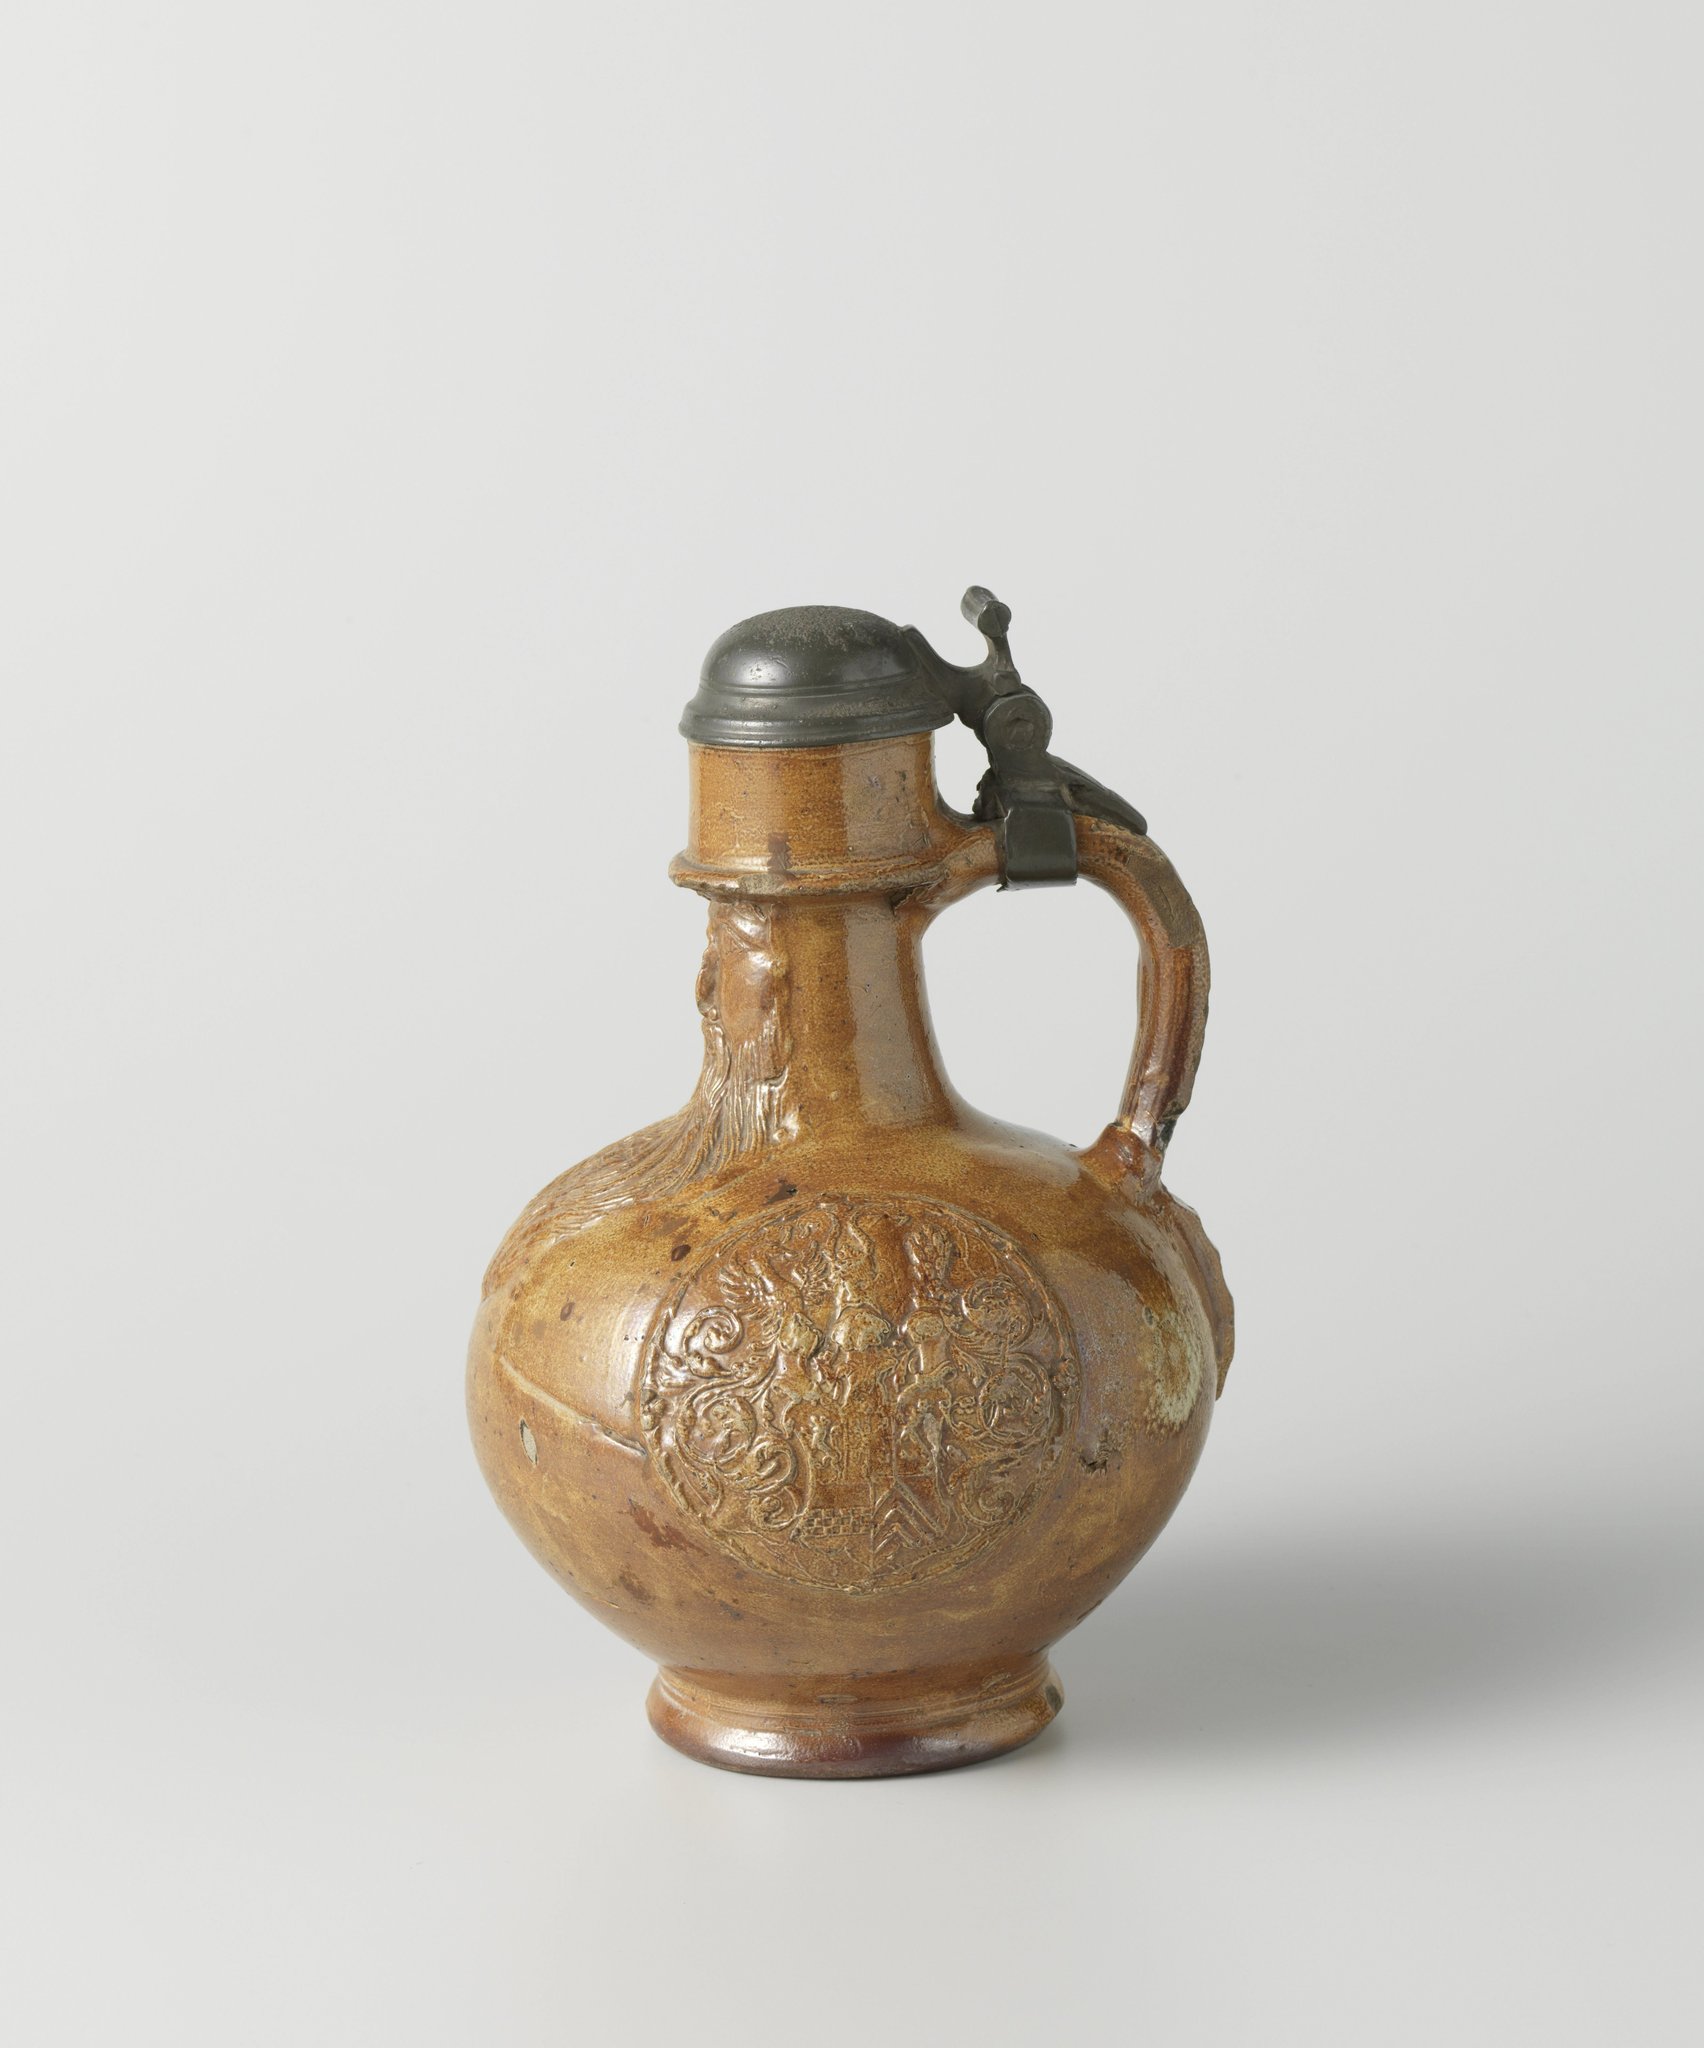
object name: jug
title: Jug (Bartmann jug) with the coat of arms of Cologne and Gulik-Kleef-Berg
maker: Anonymous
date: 1577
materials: engobe, glaze, stoneware, tin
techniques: firing, forming, relief, turning, vitrification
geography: raeren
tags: armorial bearing, heraldry, cologne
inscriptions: date: ‘1577’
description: Kruik (baardmankruik) van steengoed op standring met een bolvormig lichaam en smalle, lange nek. Het C-vormige oor is bevestigd aan de nek en de schouder. Profielen op de nek en voet. Bedekt met een bruine engobe. Op de buik twee gedrukte en opgelegde medaillons in reliëf, met daarin het wapen van Keulen en de hertog van Gulik-Kleef-Berg met de datum '1577'. Op de nek, doorlopend op de schouder en buik, een baardman. Bevestigd aan het oor een tinnen montuur met deksel. Raeren.